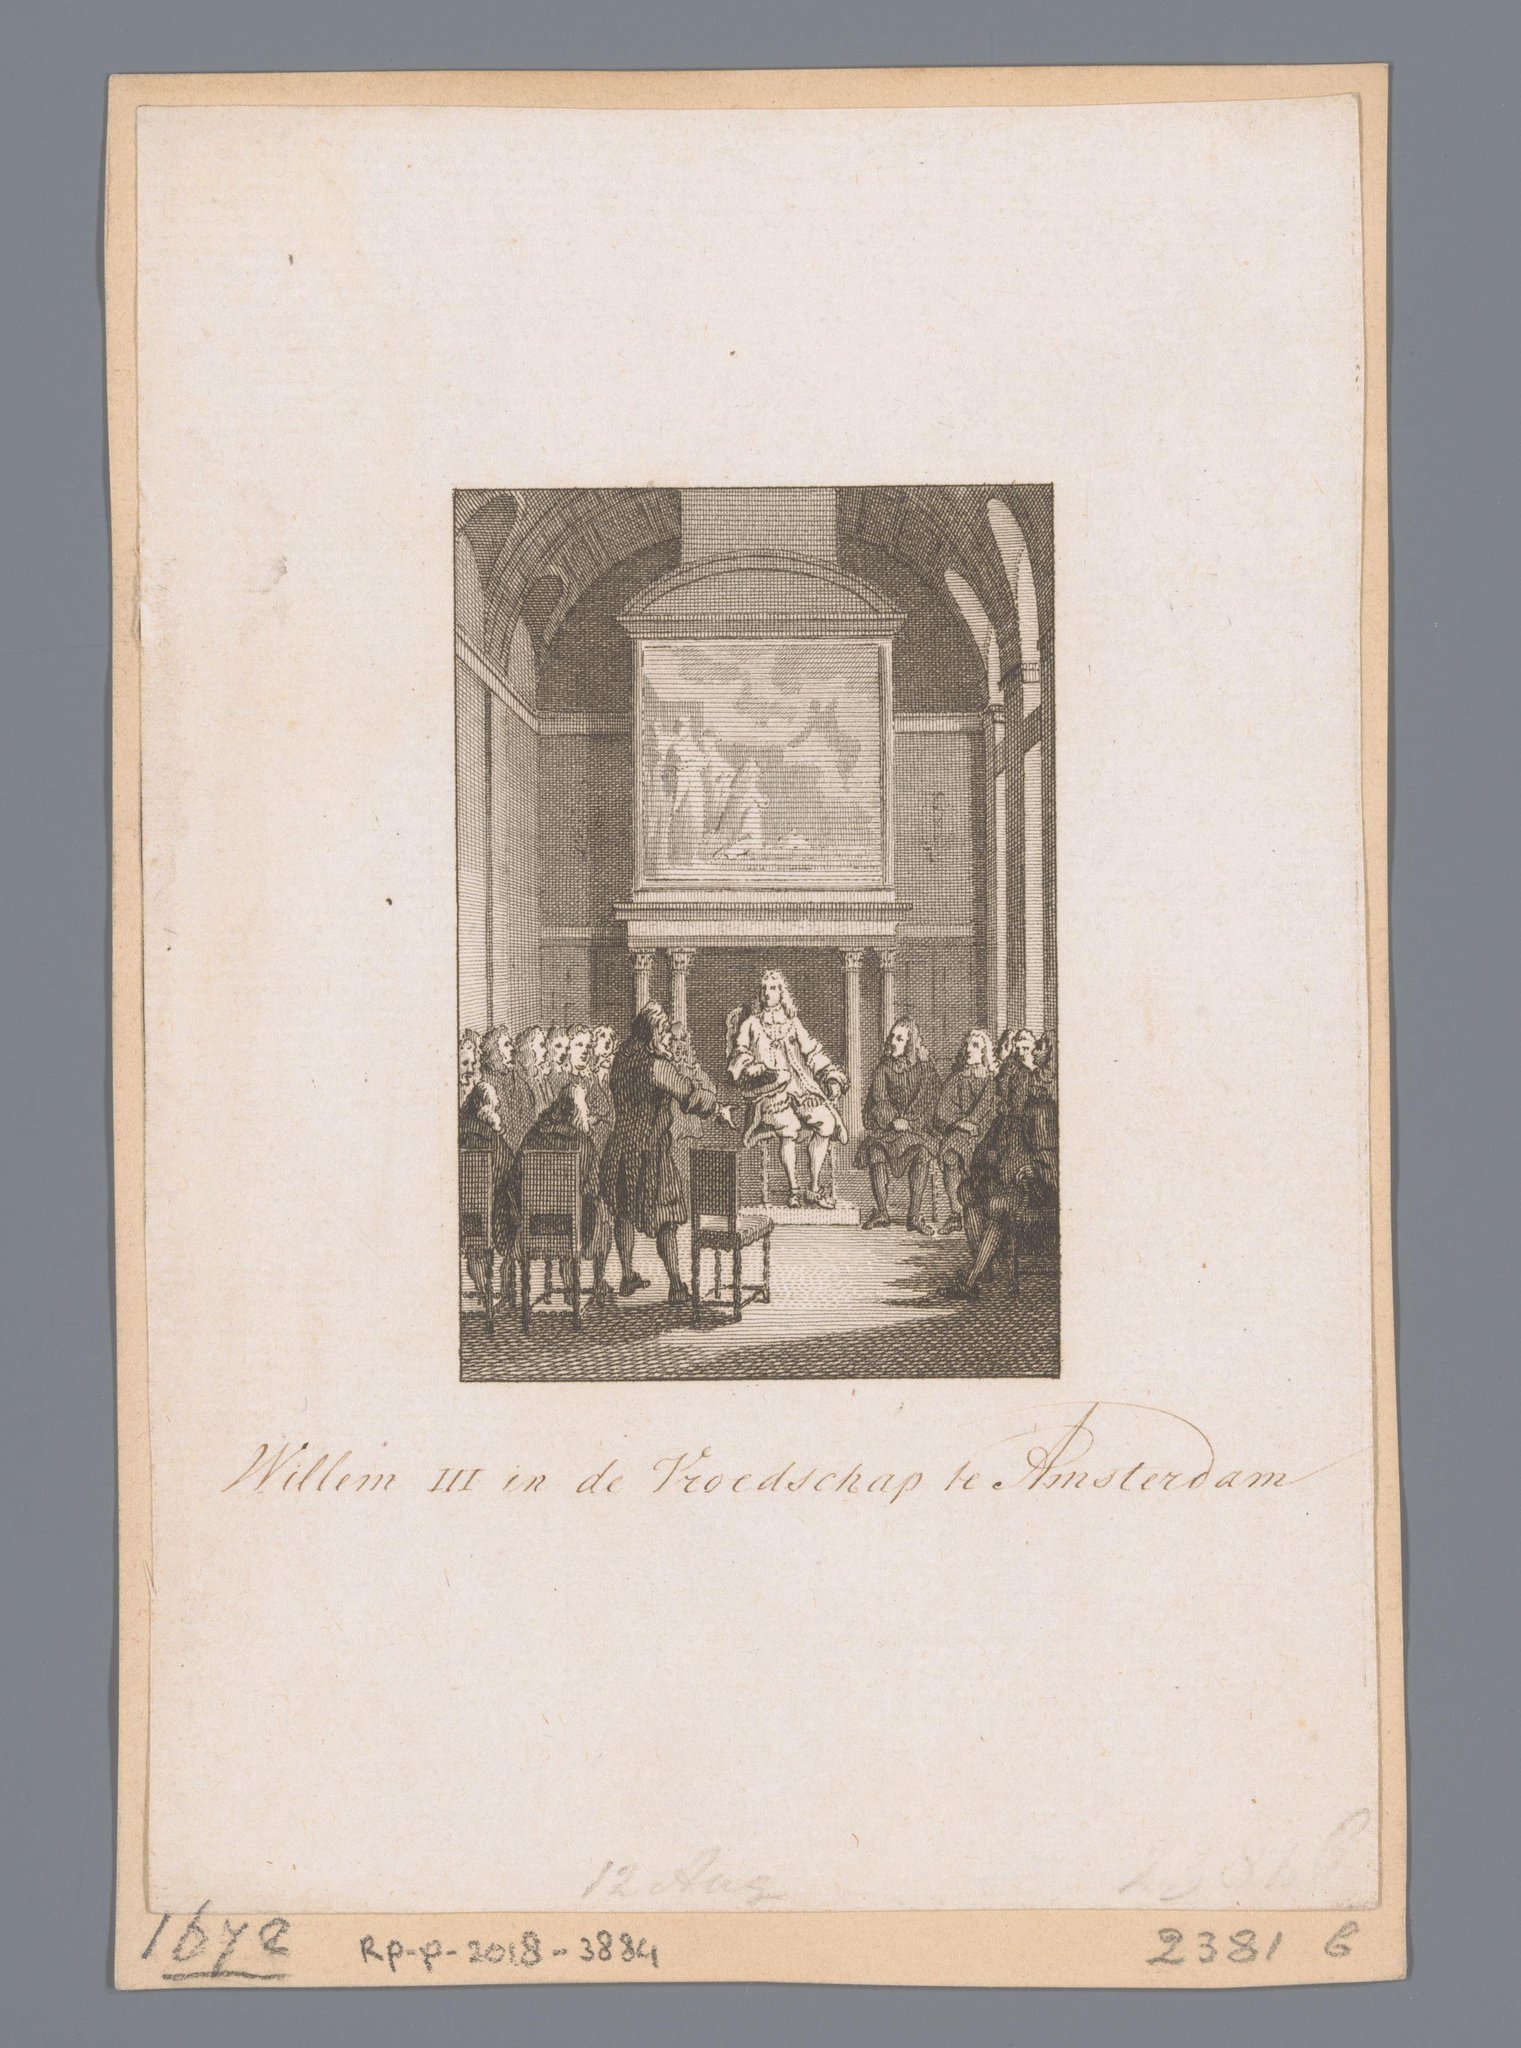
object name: print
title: Willem III in de Vroedschap te Amsterdam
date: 1780-1795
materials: paper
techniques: etching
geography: northern netherlands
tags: william iii (prince of orange and king of england, scotland, and ireland), townhall, interior ~ representation of a building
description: Gebruikt als illustratie in: J. Fokke. Geschiedenissen der Vereenigde Nederlanden voor de vaderlandsche jeugd, 25 dln. Amsterdam: Johannes Allart, 1783-1795, dl. X, pl. I.